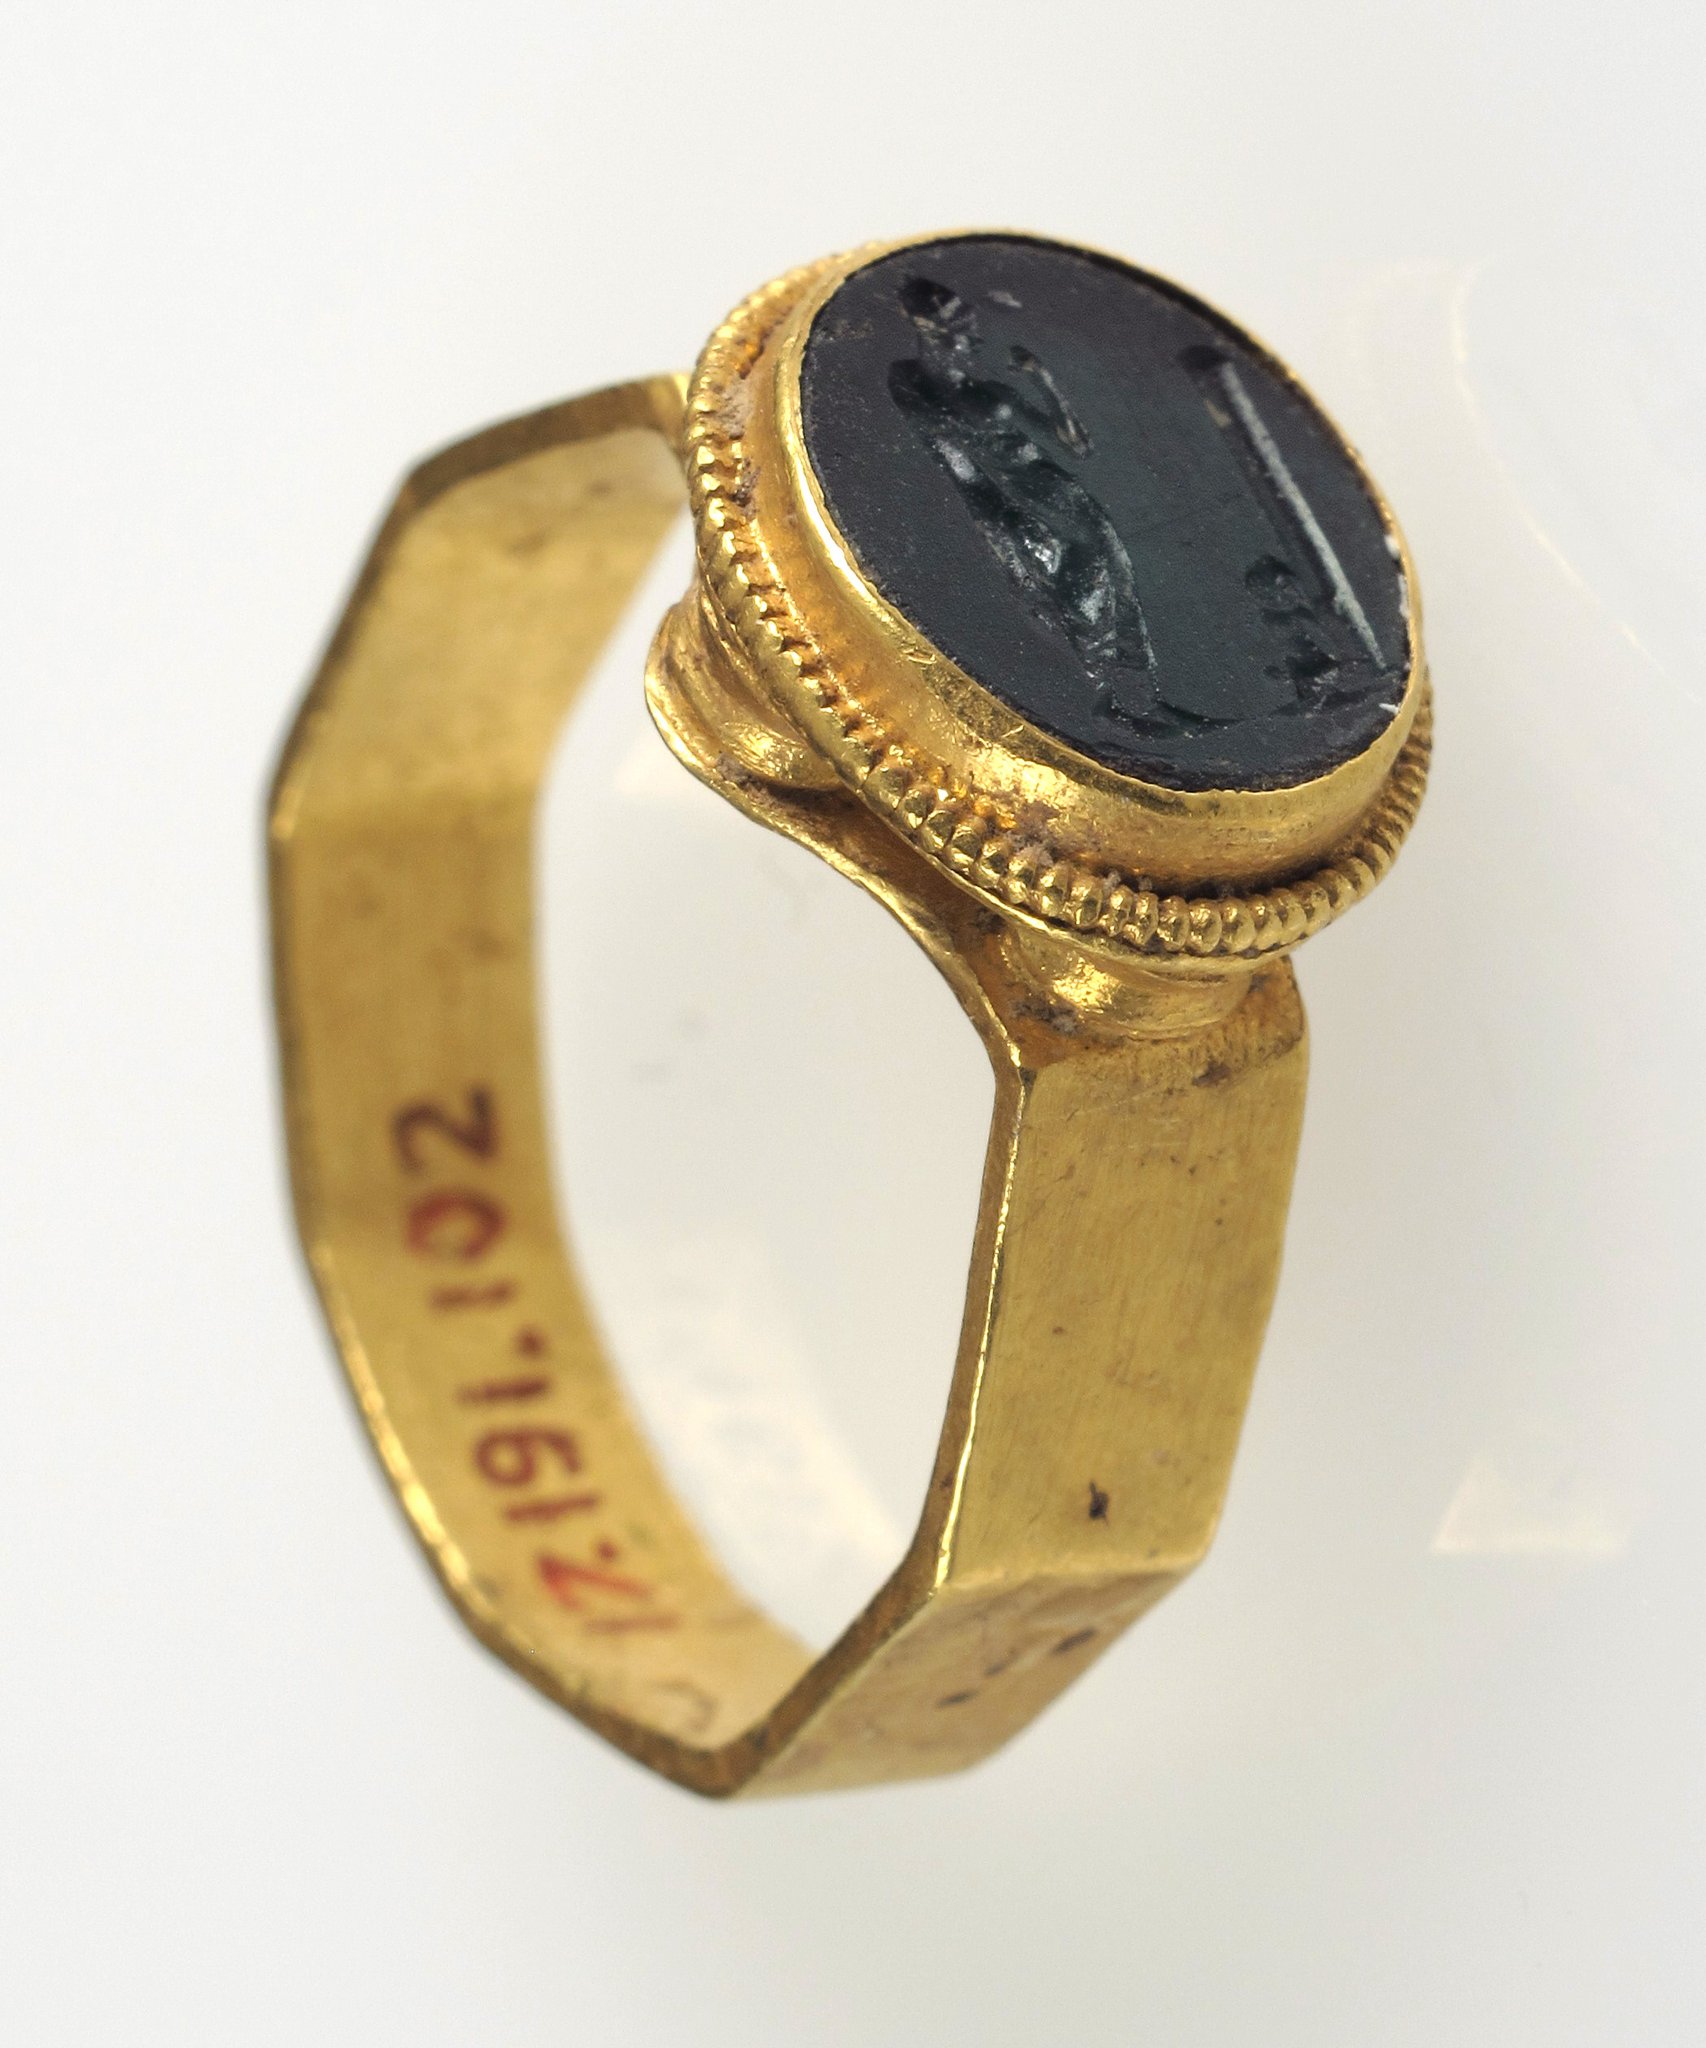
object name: ring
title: Finger Ring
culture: frankish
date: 501-700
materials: gold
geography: northern france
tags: human figures